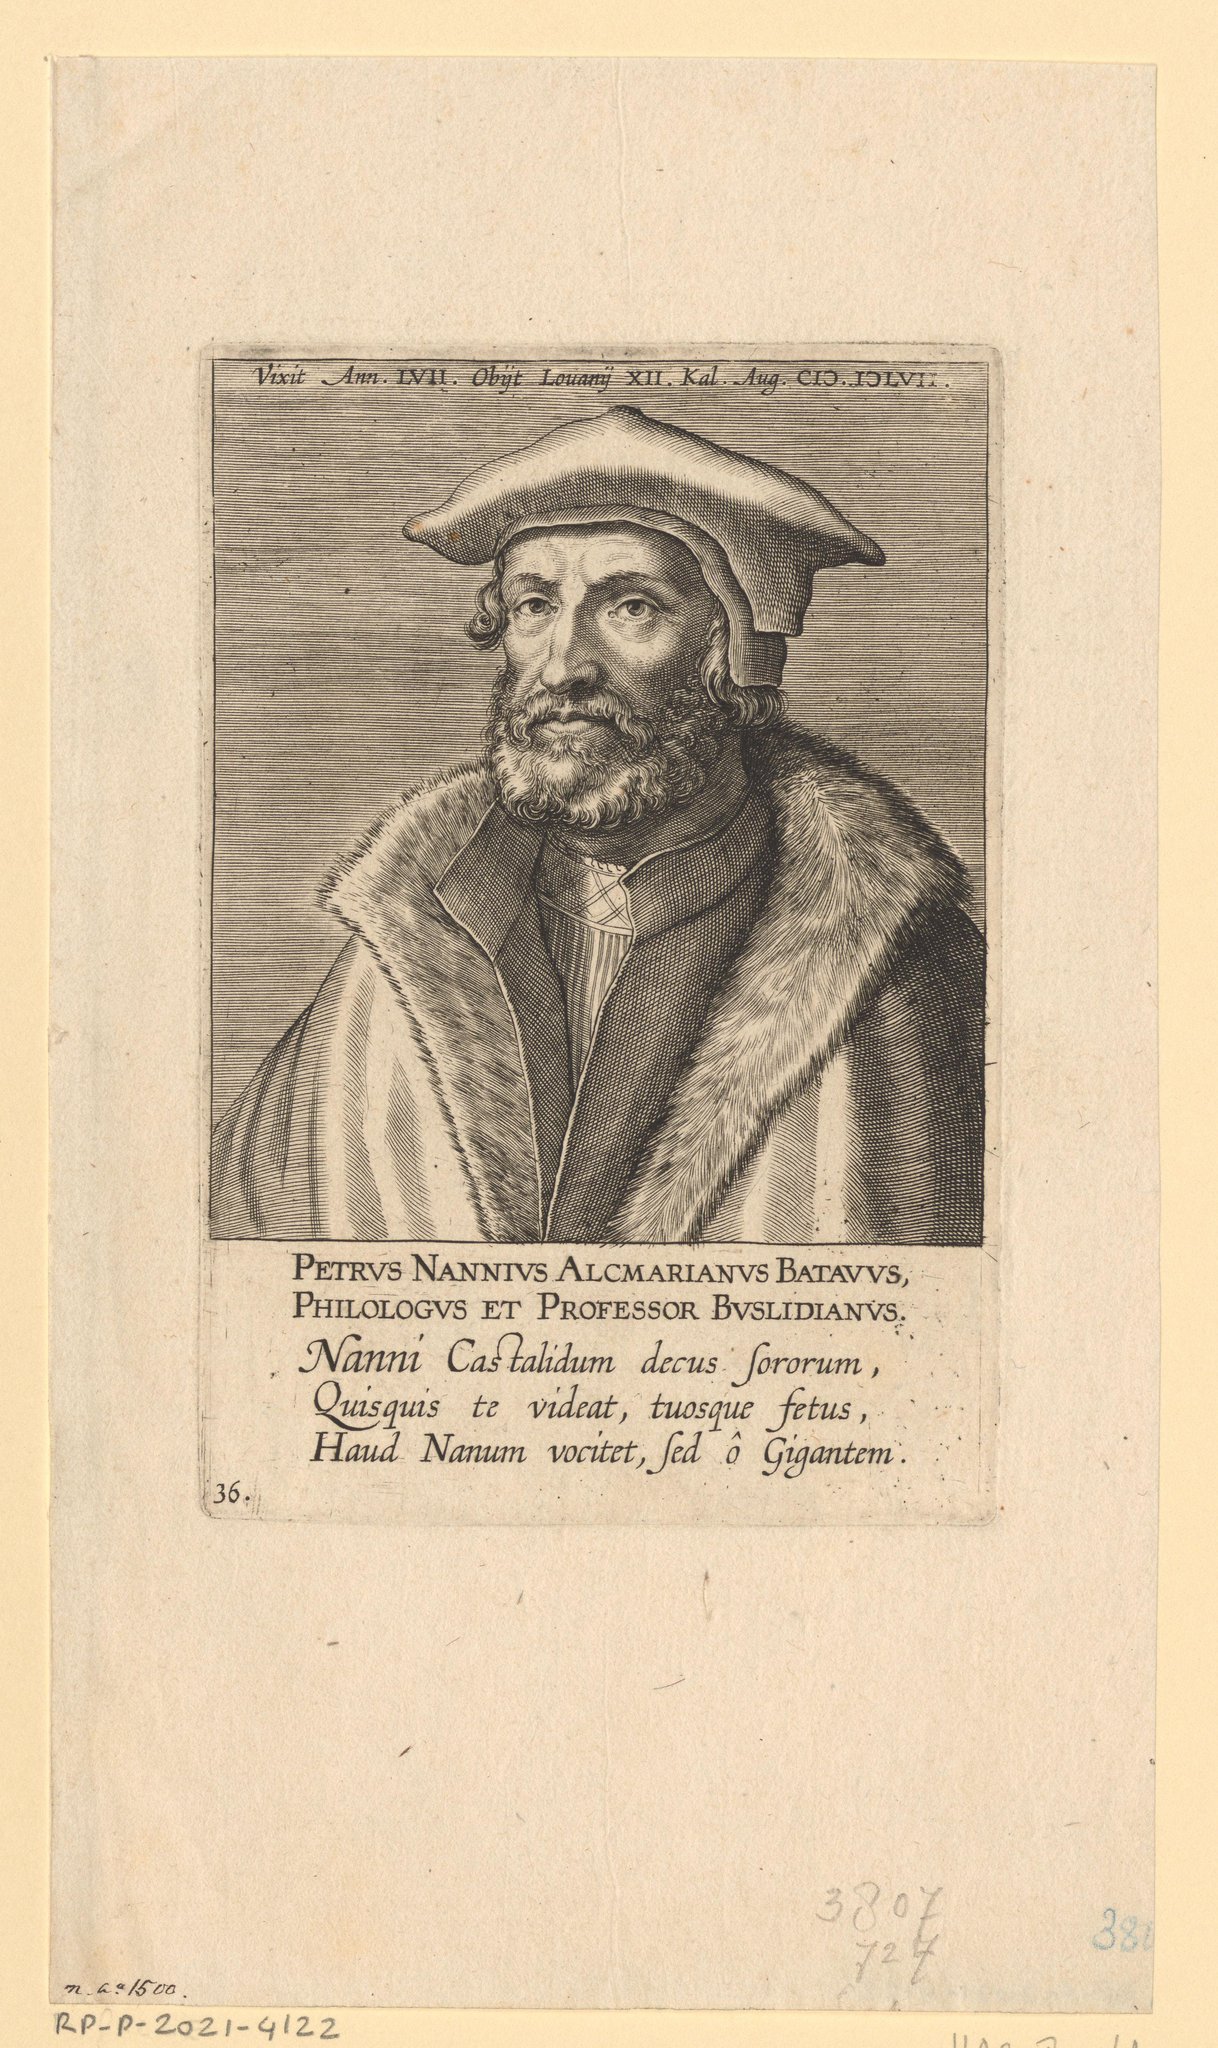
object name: print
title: Portret van Petrus Nannius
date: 1604-1608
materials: paper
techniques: engraving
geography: antwerp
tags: louvain, historical persons, writer, poet, author, professor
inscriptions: inscription: ‘n. a. 1500’